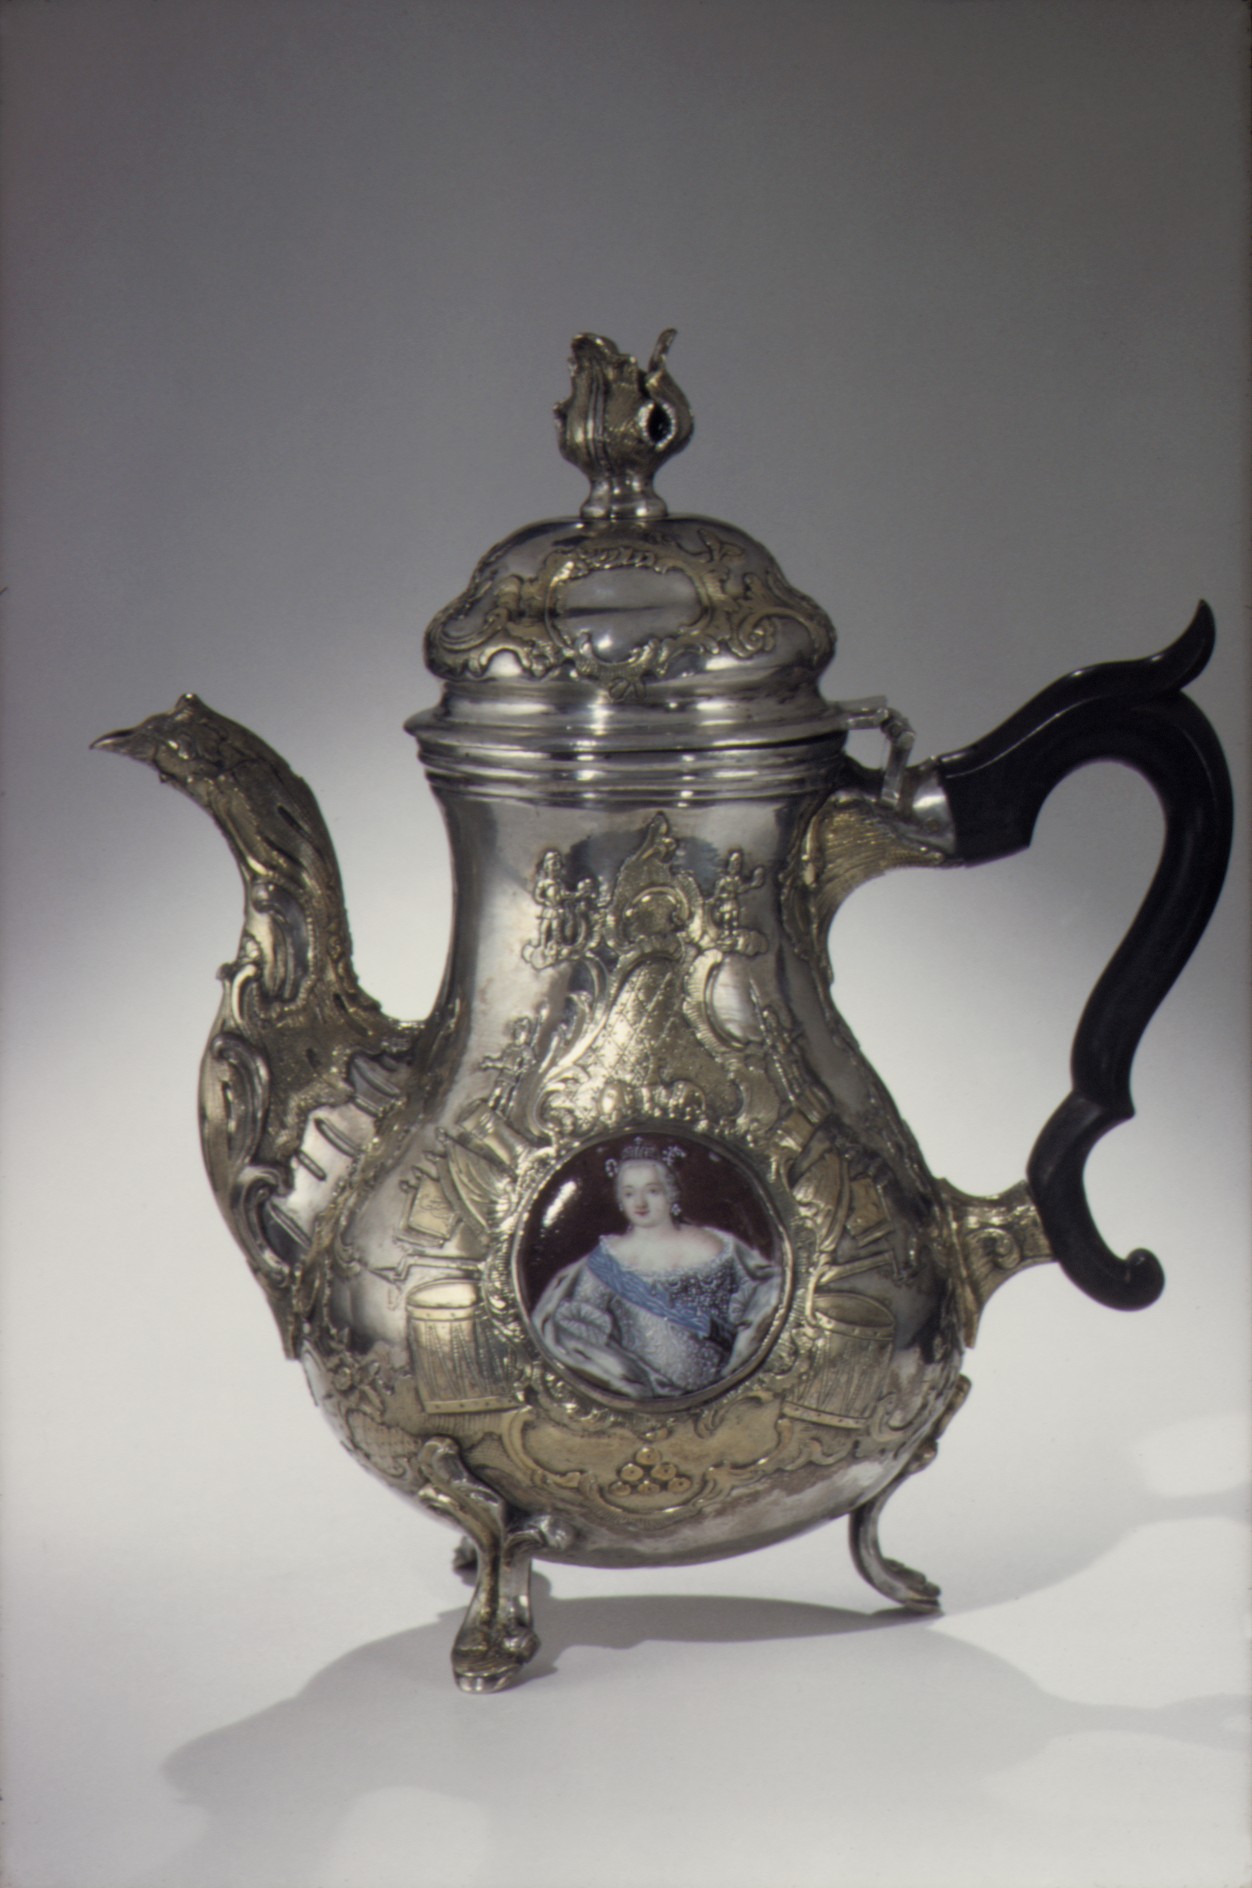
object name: teapot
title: Teapot (part of a set)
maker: johan henrik blom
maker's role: maker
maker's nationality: finish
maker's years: 1705-1805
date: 1773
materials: enamel, gilt, silver, wood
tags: portraits,women